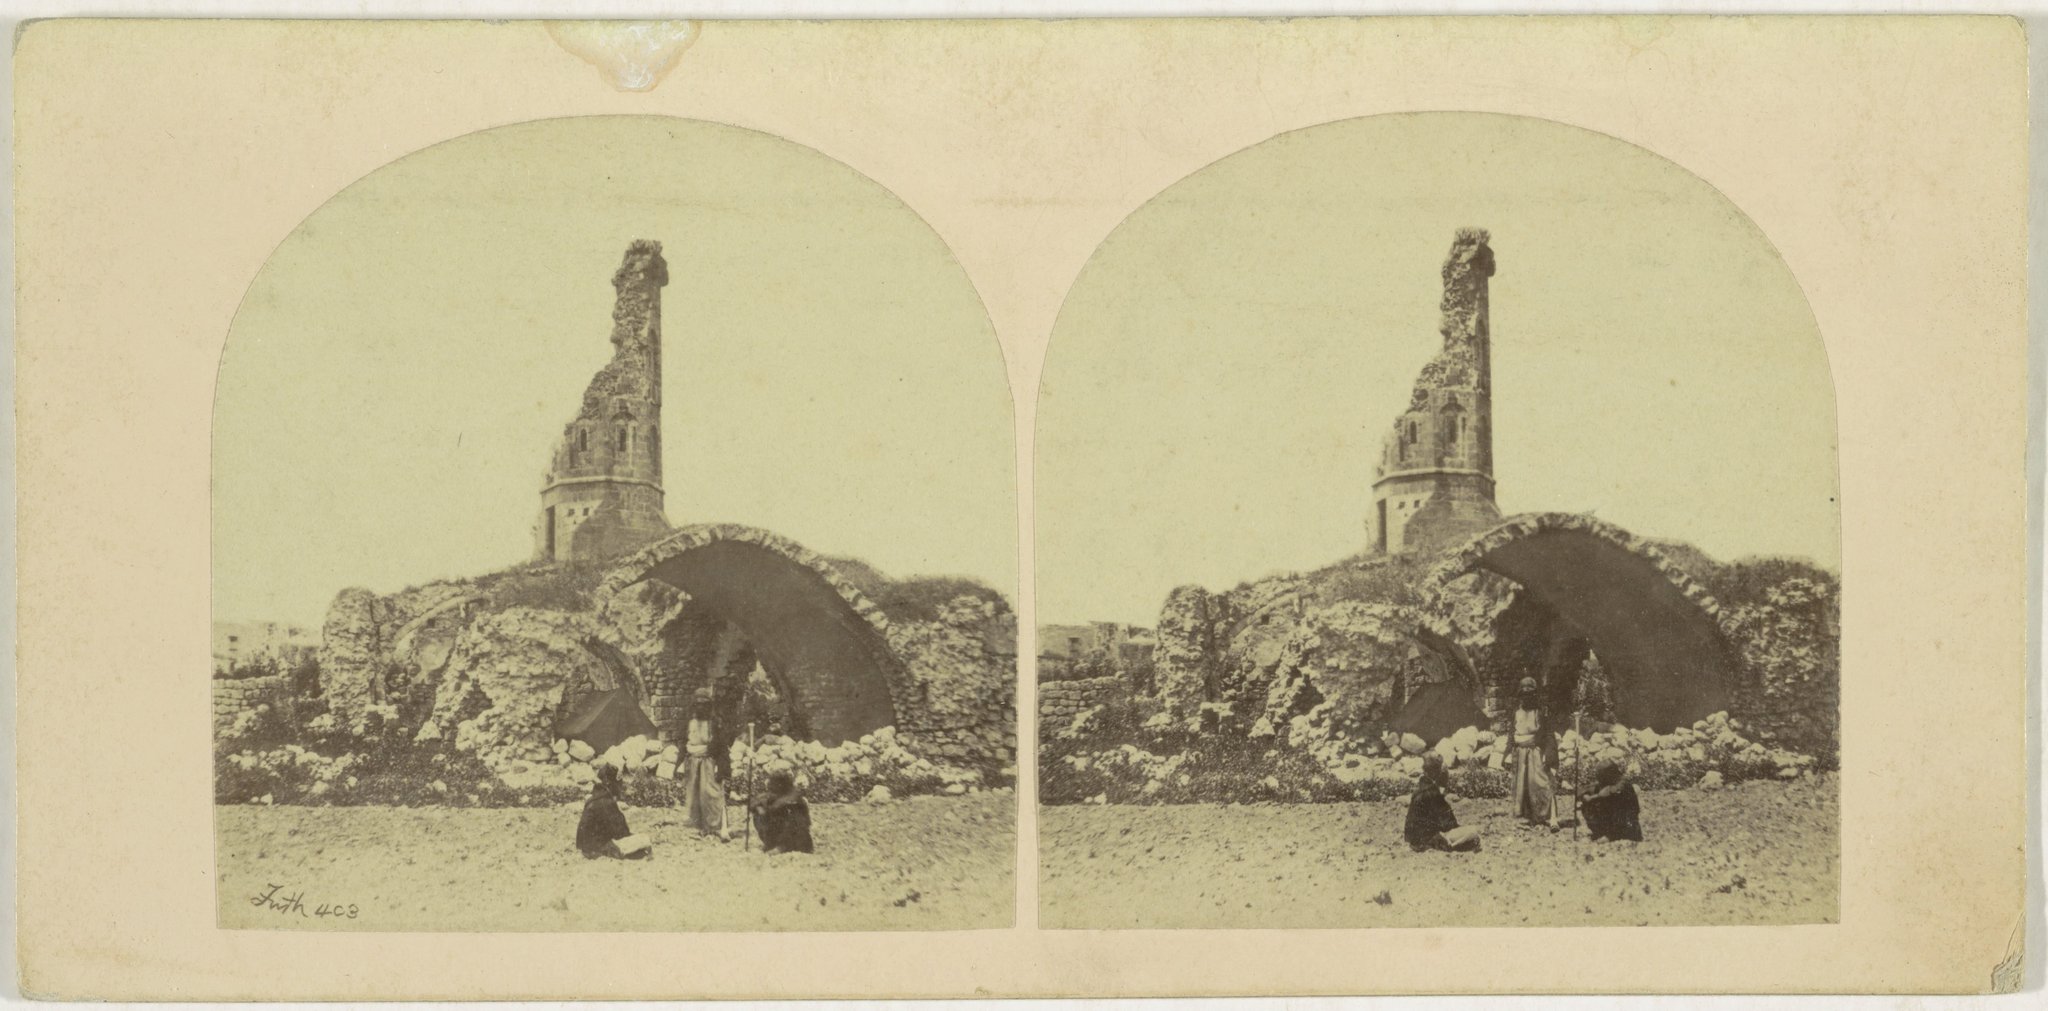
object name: stereograph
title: Views in the Holy Land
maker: francis frith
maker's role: publisher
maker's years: 1822-1898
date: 1859-1861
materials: cardboard, paper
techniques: albumen print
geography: ramla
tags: ruin of a building ~ architecture, temple, shrine ~ islam, mohammedanism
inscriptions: number: ‘403’, inscription: ‘Ramleh is the ancient Arimathea, the birthplace of Joseph and Nicodemus, the faithful disciples who/ buried the Saviour. (...)’, inscription: ‘Entered at Stationers' Hall.]’, inscription: ‘[Deposé.’, inscription: ‘Ruine d'une Mosqueé à Ramlehe (eâte'de l'Est)’